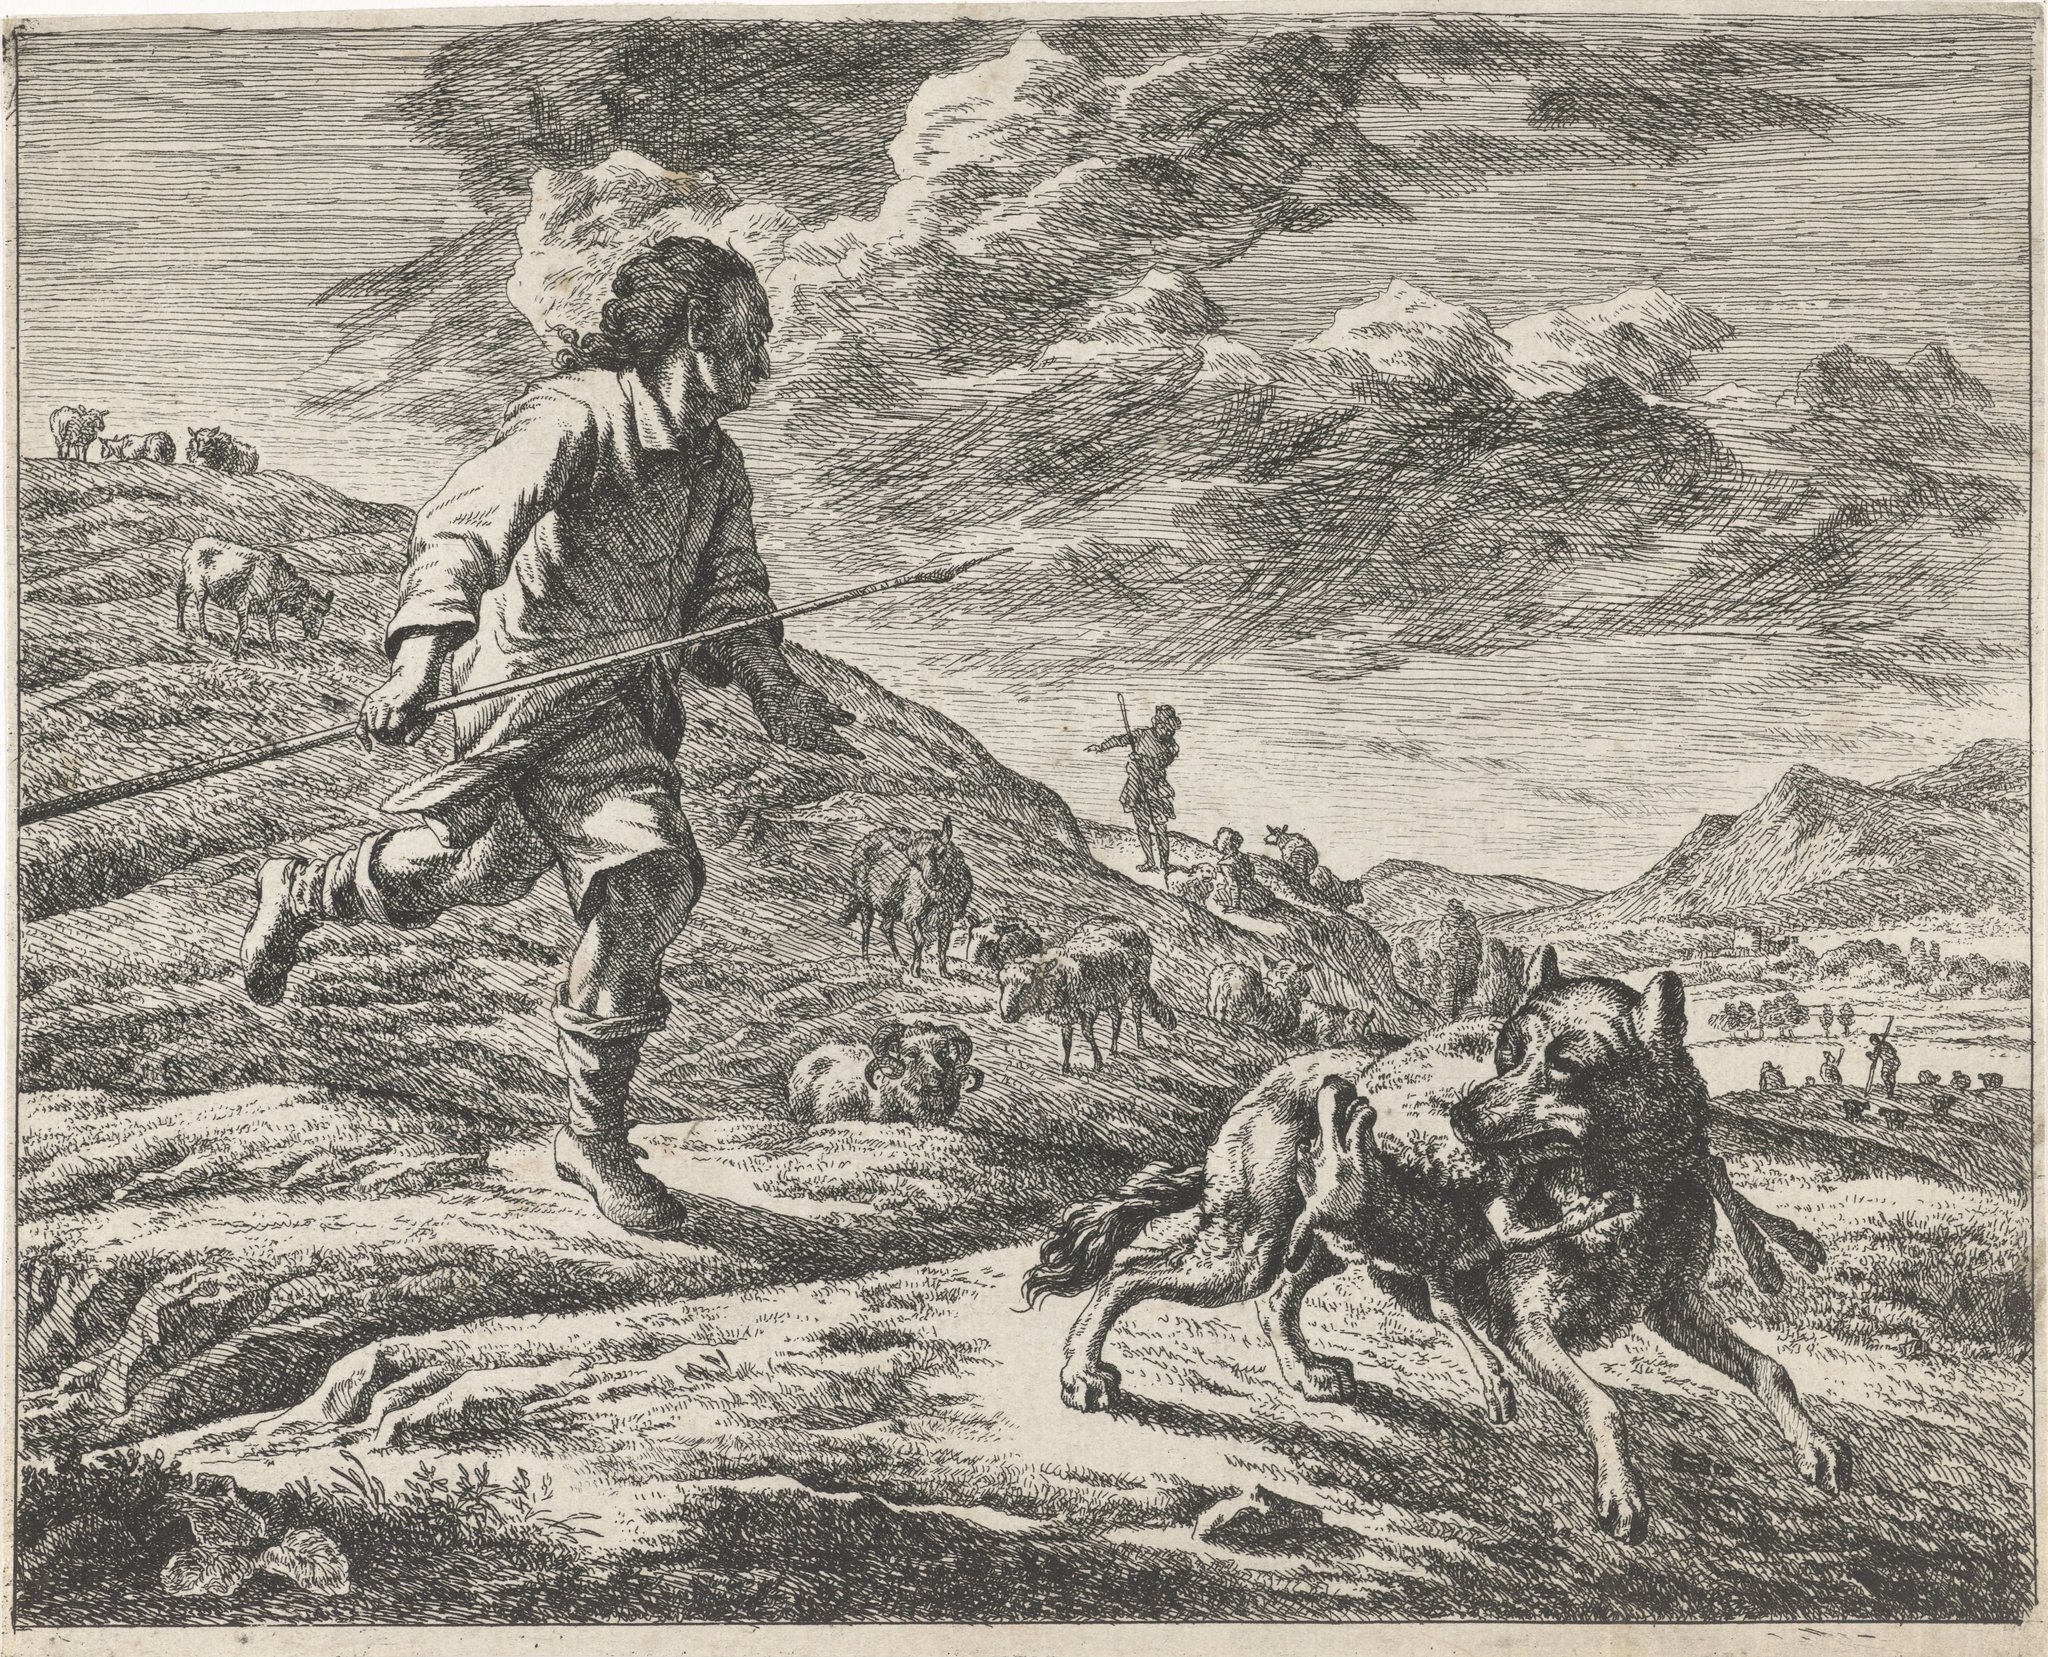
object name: print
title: Herder achtervolgt een wolf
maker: johan le ducq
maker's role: draughtsman, print maker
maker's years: 1629-1677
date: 1639-1677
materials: paper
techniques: etching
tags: herding, herdsman, herdswoman, shepherd, shepherdess, cowherd, etc., sheep, beasts of prey, predatory animals: wolf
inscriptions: collector's mark: Lugt 2228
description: Een herder achtervolgt met een speer een wolf die een lam heeft gedood en dit in zijn bek houdt. Op de achtergrond een kudde schapen.